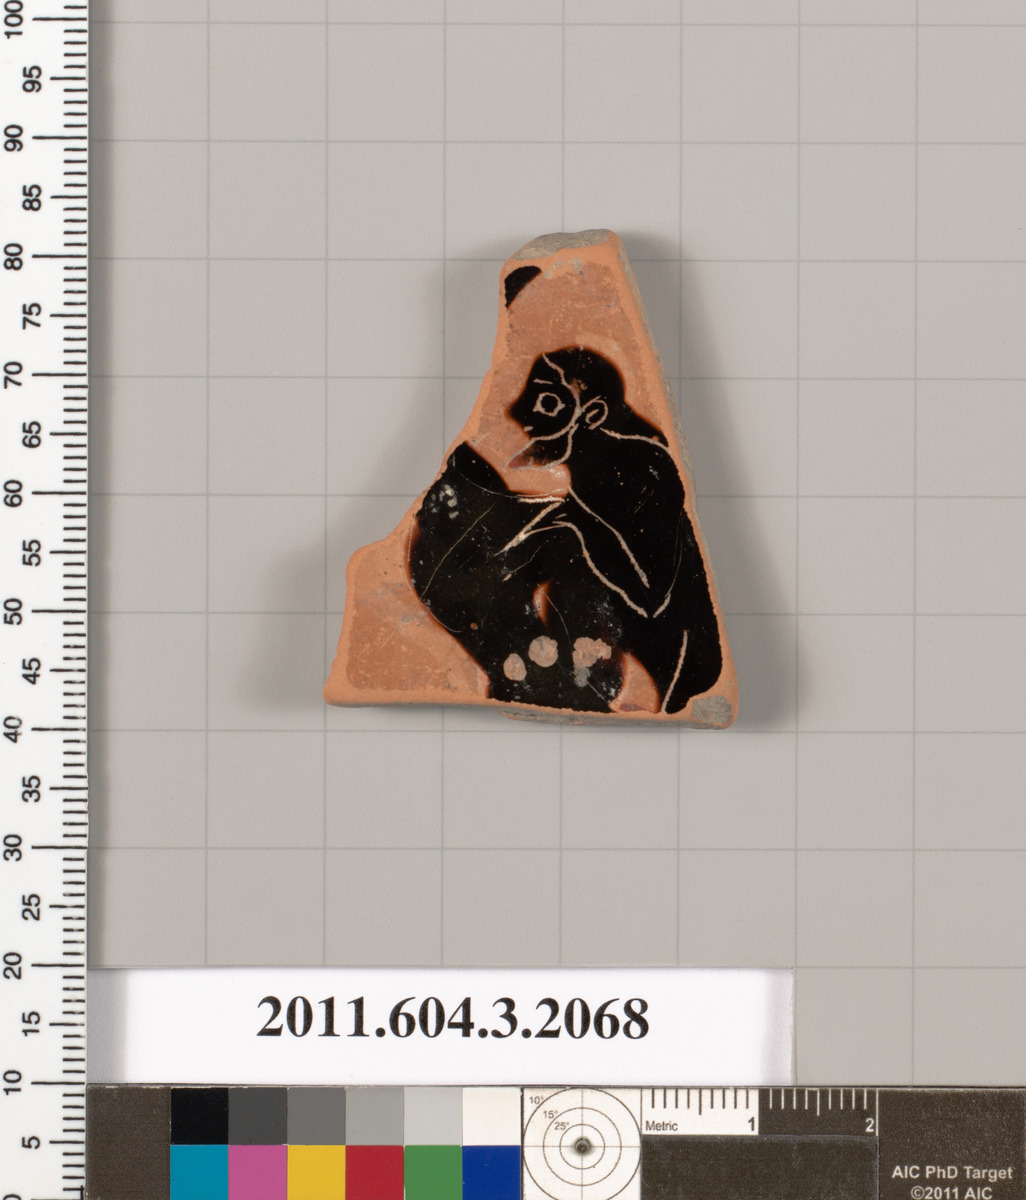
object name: kylix fragment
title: Terracotta fragment of a kylix (drinking cup)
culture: greek, attic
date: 534-468 BCE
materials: terracotta